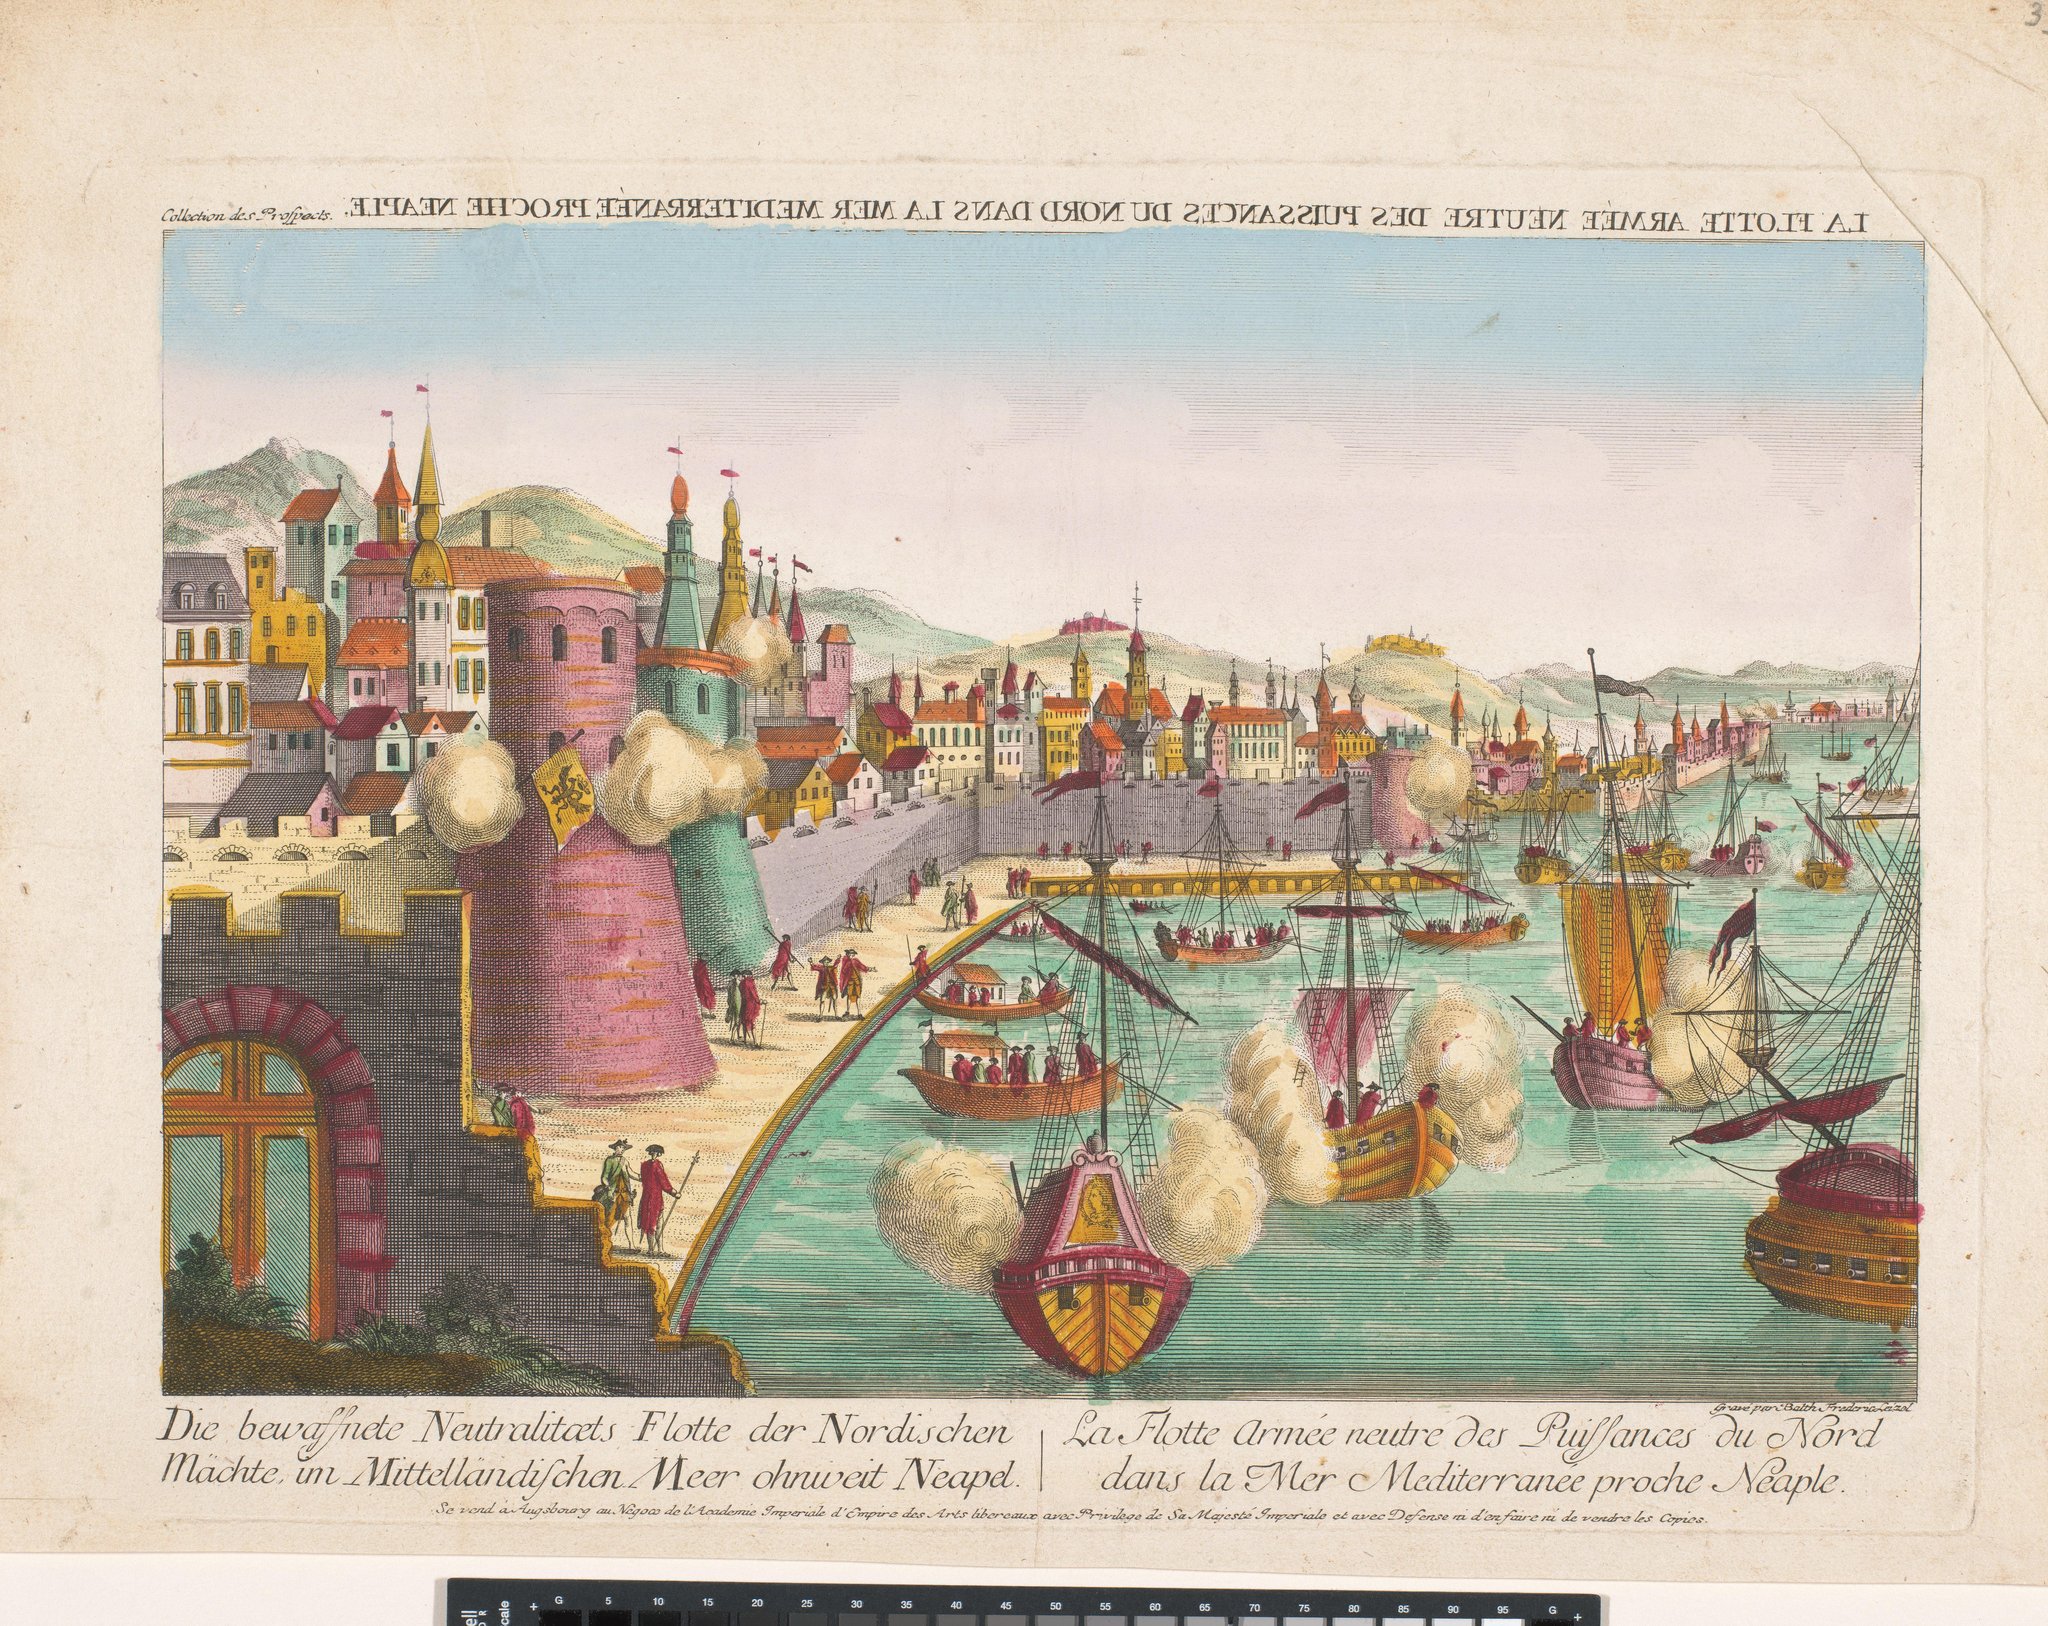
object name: opticaprent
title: Gezicht op de oorlogsvloot van een noordelijke macht in de haven te Napels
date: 1755-1779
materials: paper, watercolor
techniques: brush, etching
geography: augsburg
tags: harbour, sailing-ship, sailing-boat, battle, rowing-boat, canoe, etc., sea (seascape) (+ landscape with figures, staffage), civic architecture; edifices; dwellings, naples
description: De versterkte bouwwerken aan de waterkant en de schepen in de haven vuren kanonnen op elkaar af.